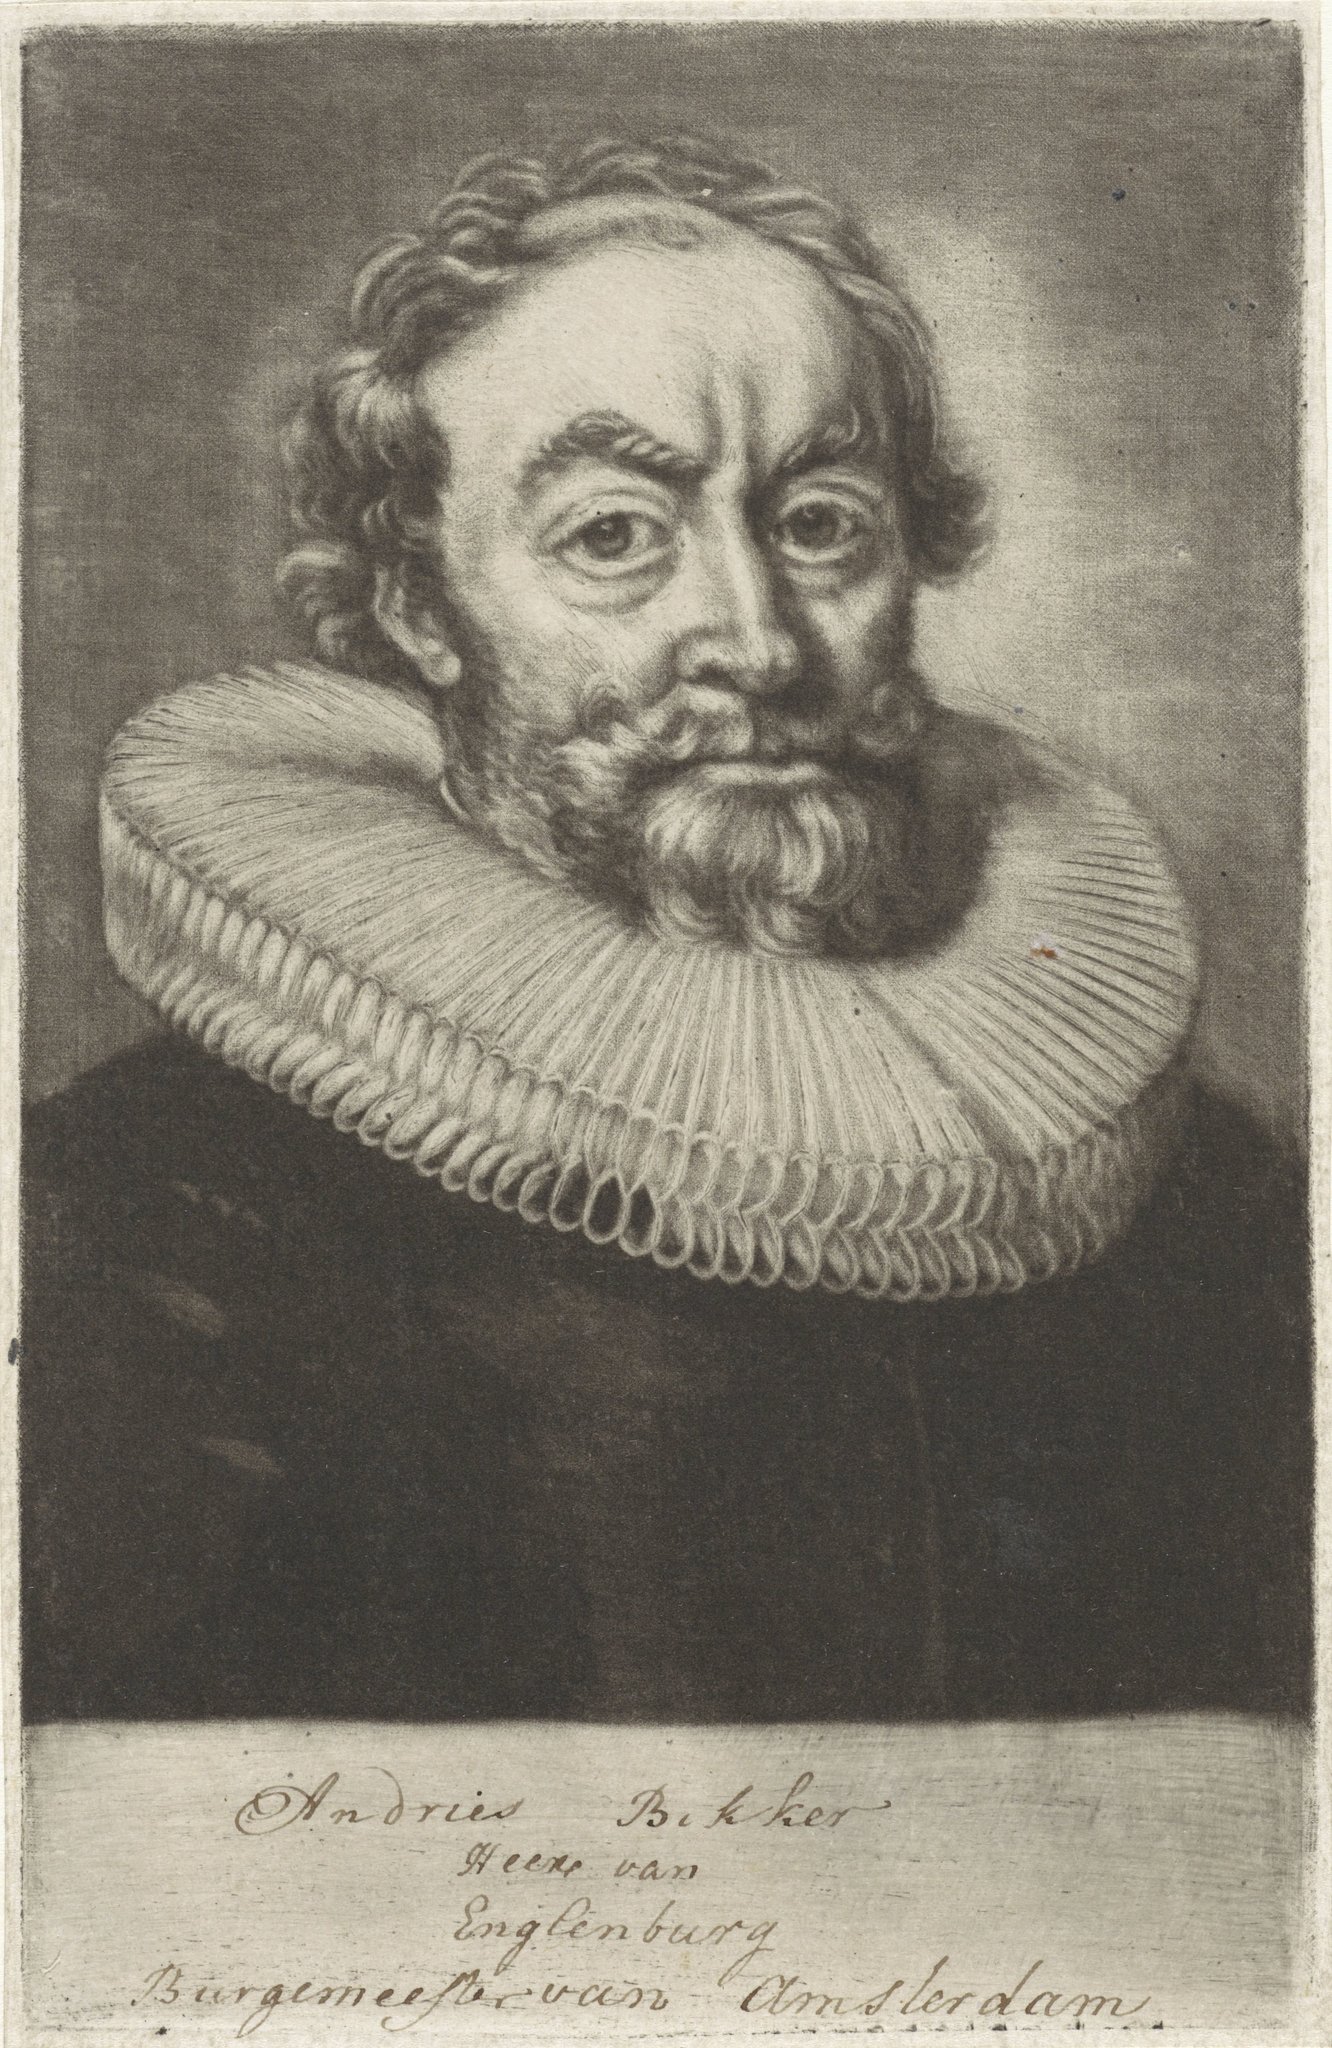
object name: print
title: Portret van Andries Bicker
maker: johannes van vilsteren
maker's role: print maker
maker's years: -1763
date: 1756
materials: paper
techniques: mezzotint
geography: northern netherlands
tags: mayor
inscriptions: collector's mark: Lugt 2228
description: Andries Bicker, koopman op Rusland en burgemeester van Amsterdam.